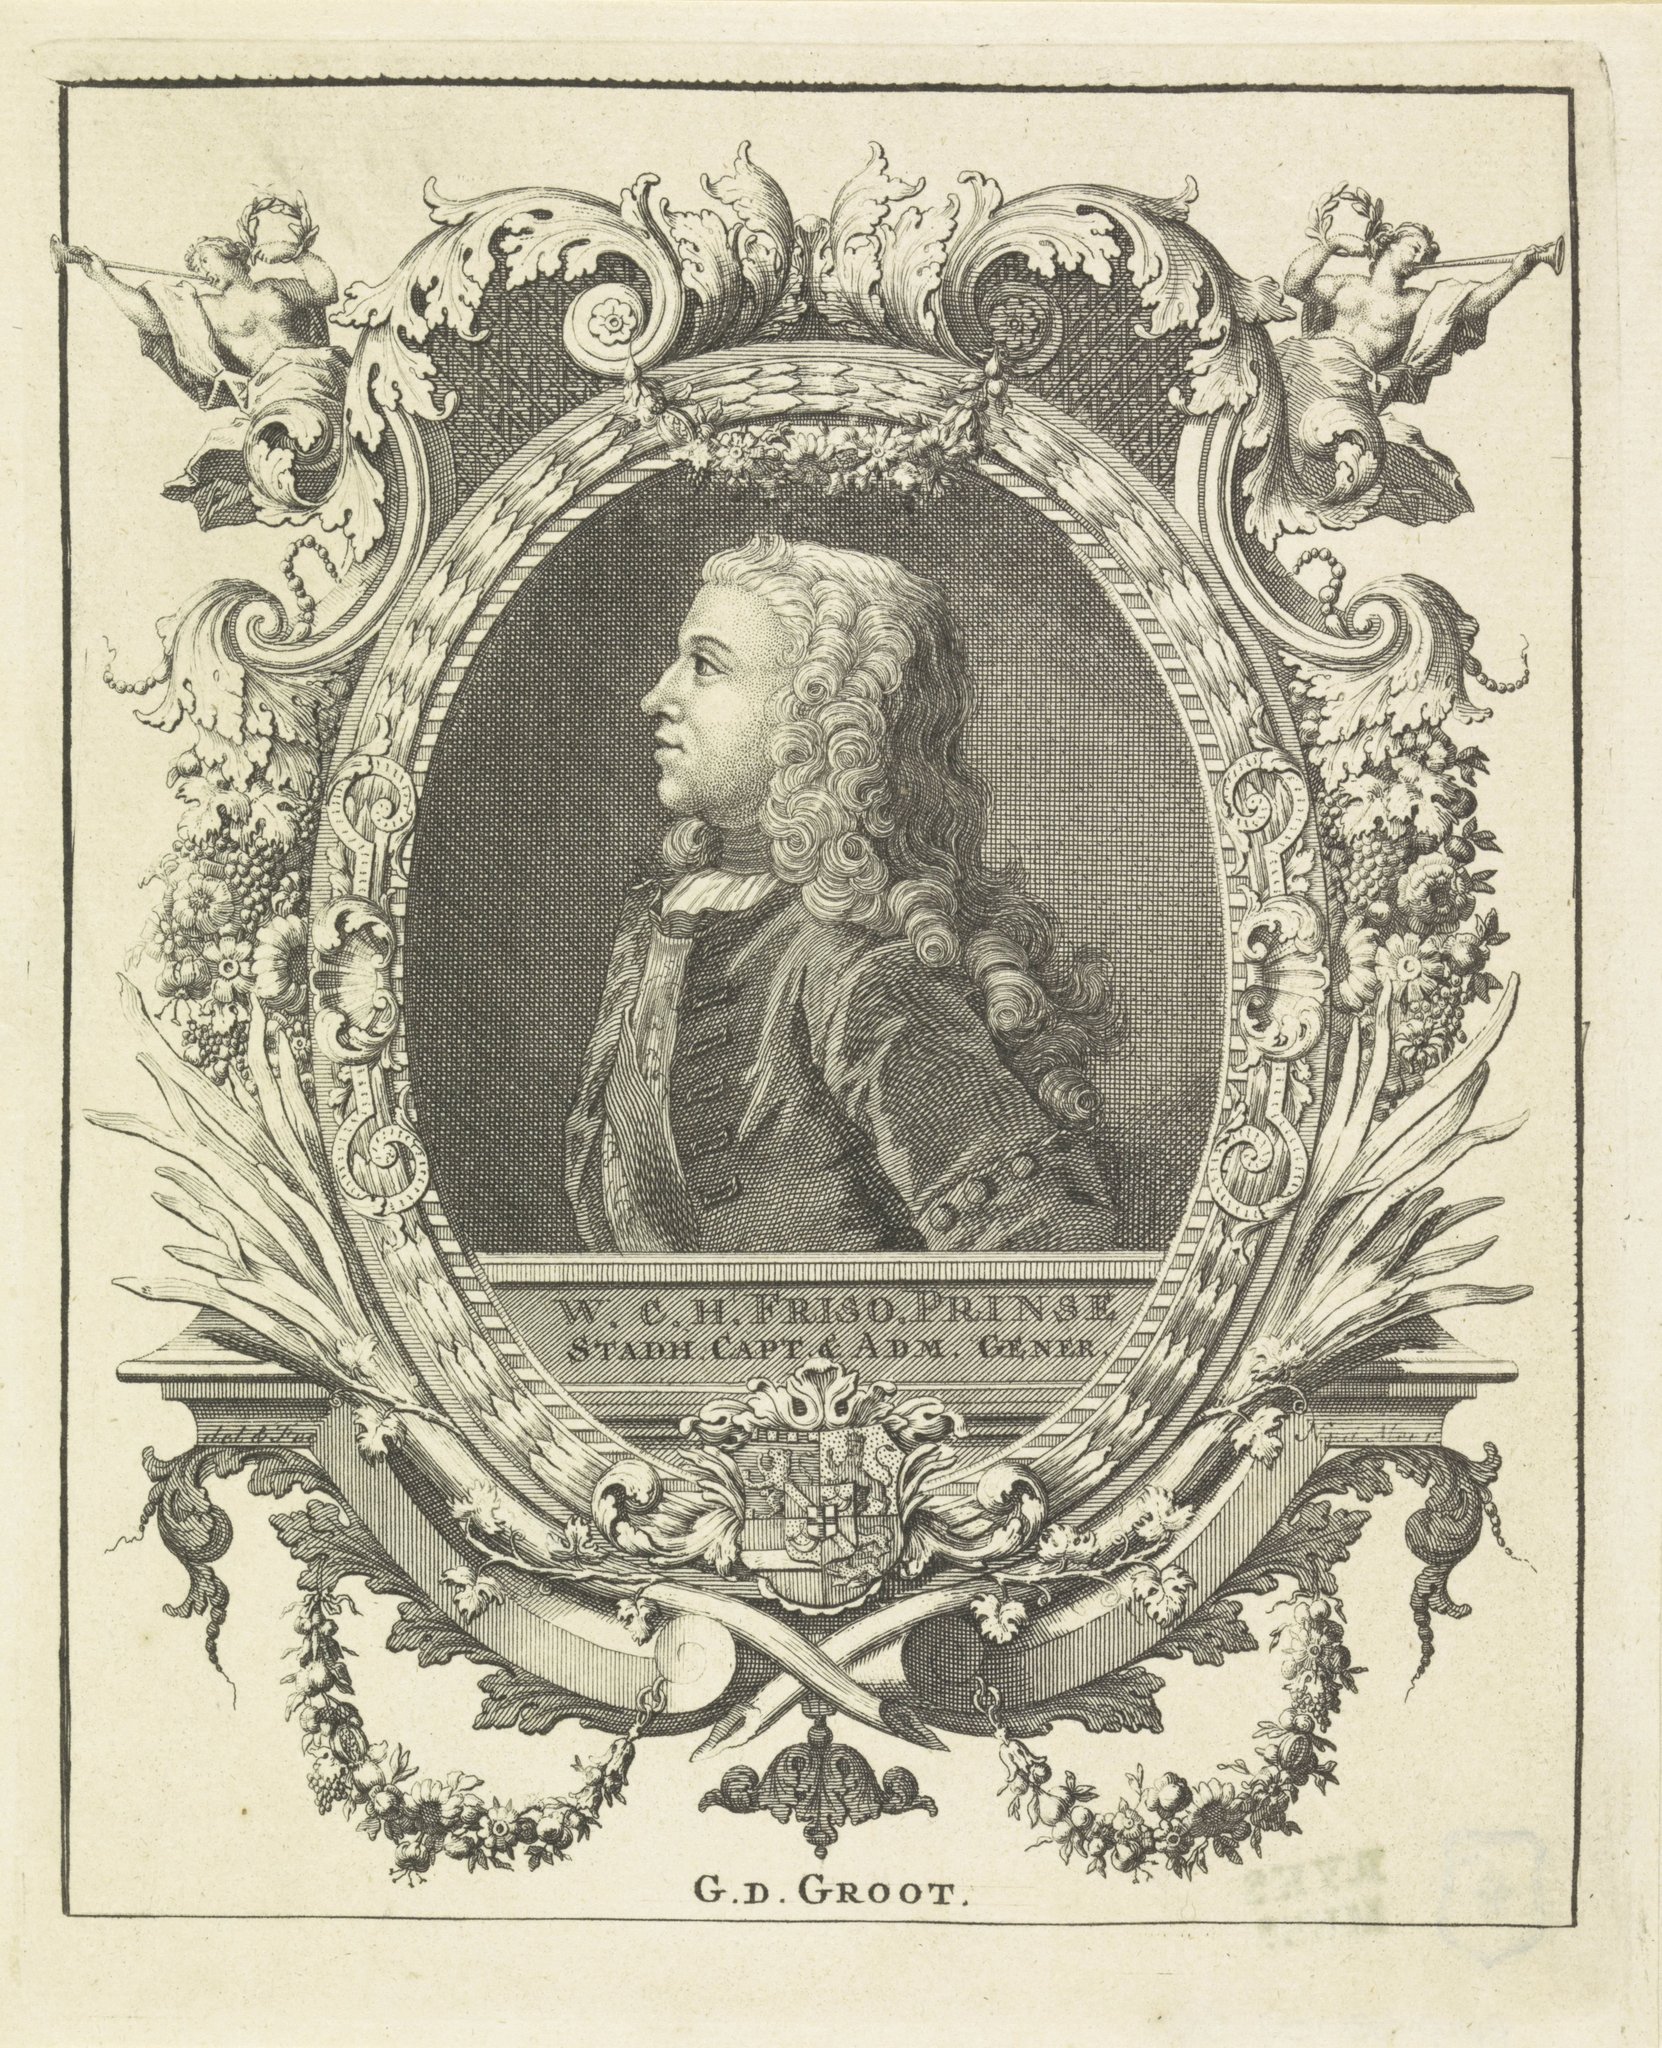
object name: print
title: Portret van Willem IV, prins van Oranje-Nassau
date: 1738-1751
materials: paper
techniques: engraving, etching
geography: leiden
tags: the hague, willem iv (prins van oranje-nassau)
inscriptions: collector's mark: Lugt 963, collector's mark: Lugt 2165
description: De hier vermelde titel verwijst naar de hoogst verkregen titel van de geportretteerde, niet per se naar de titel die de geportretteerde op deze voorstelling draagt.